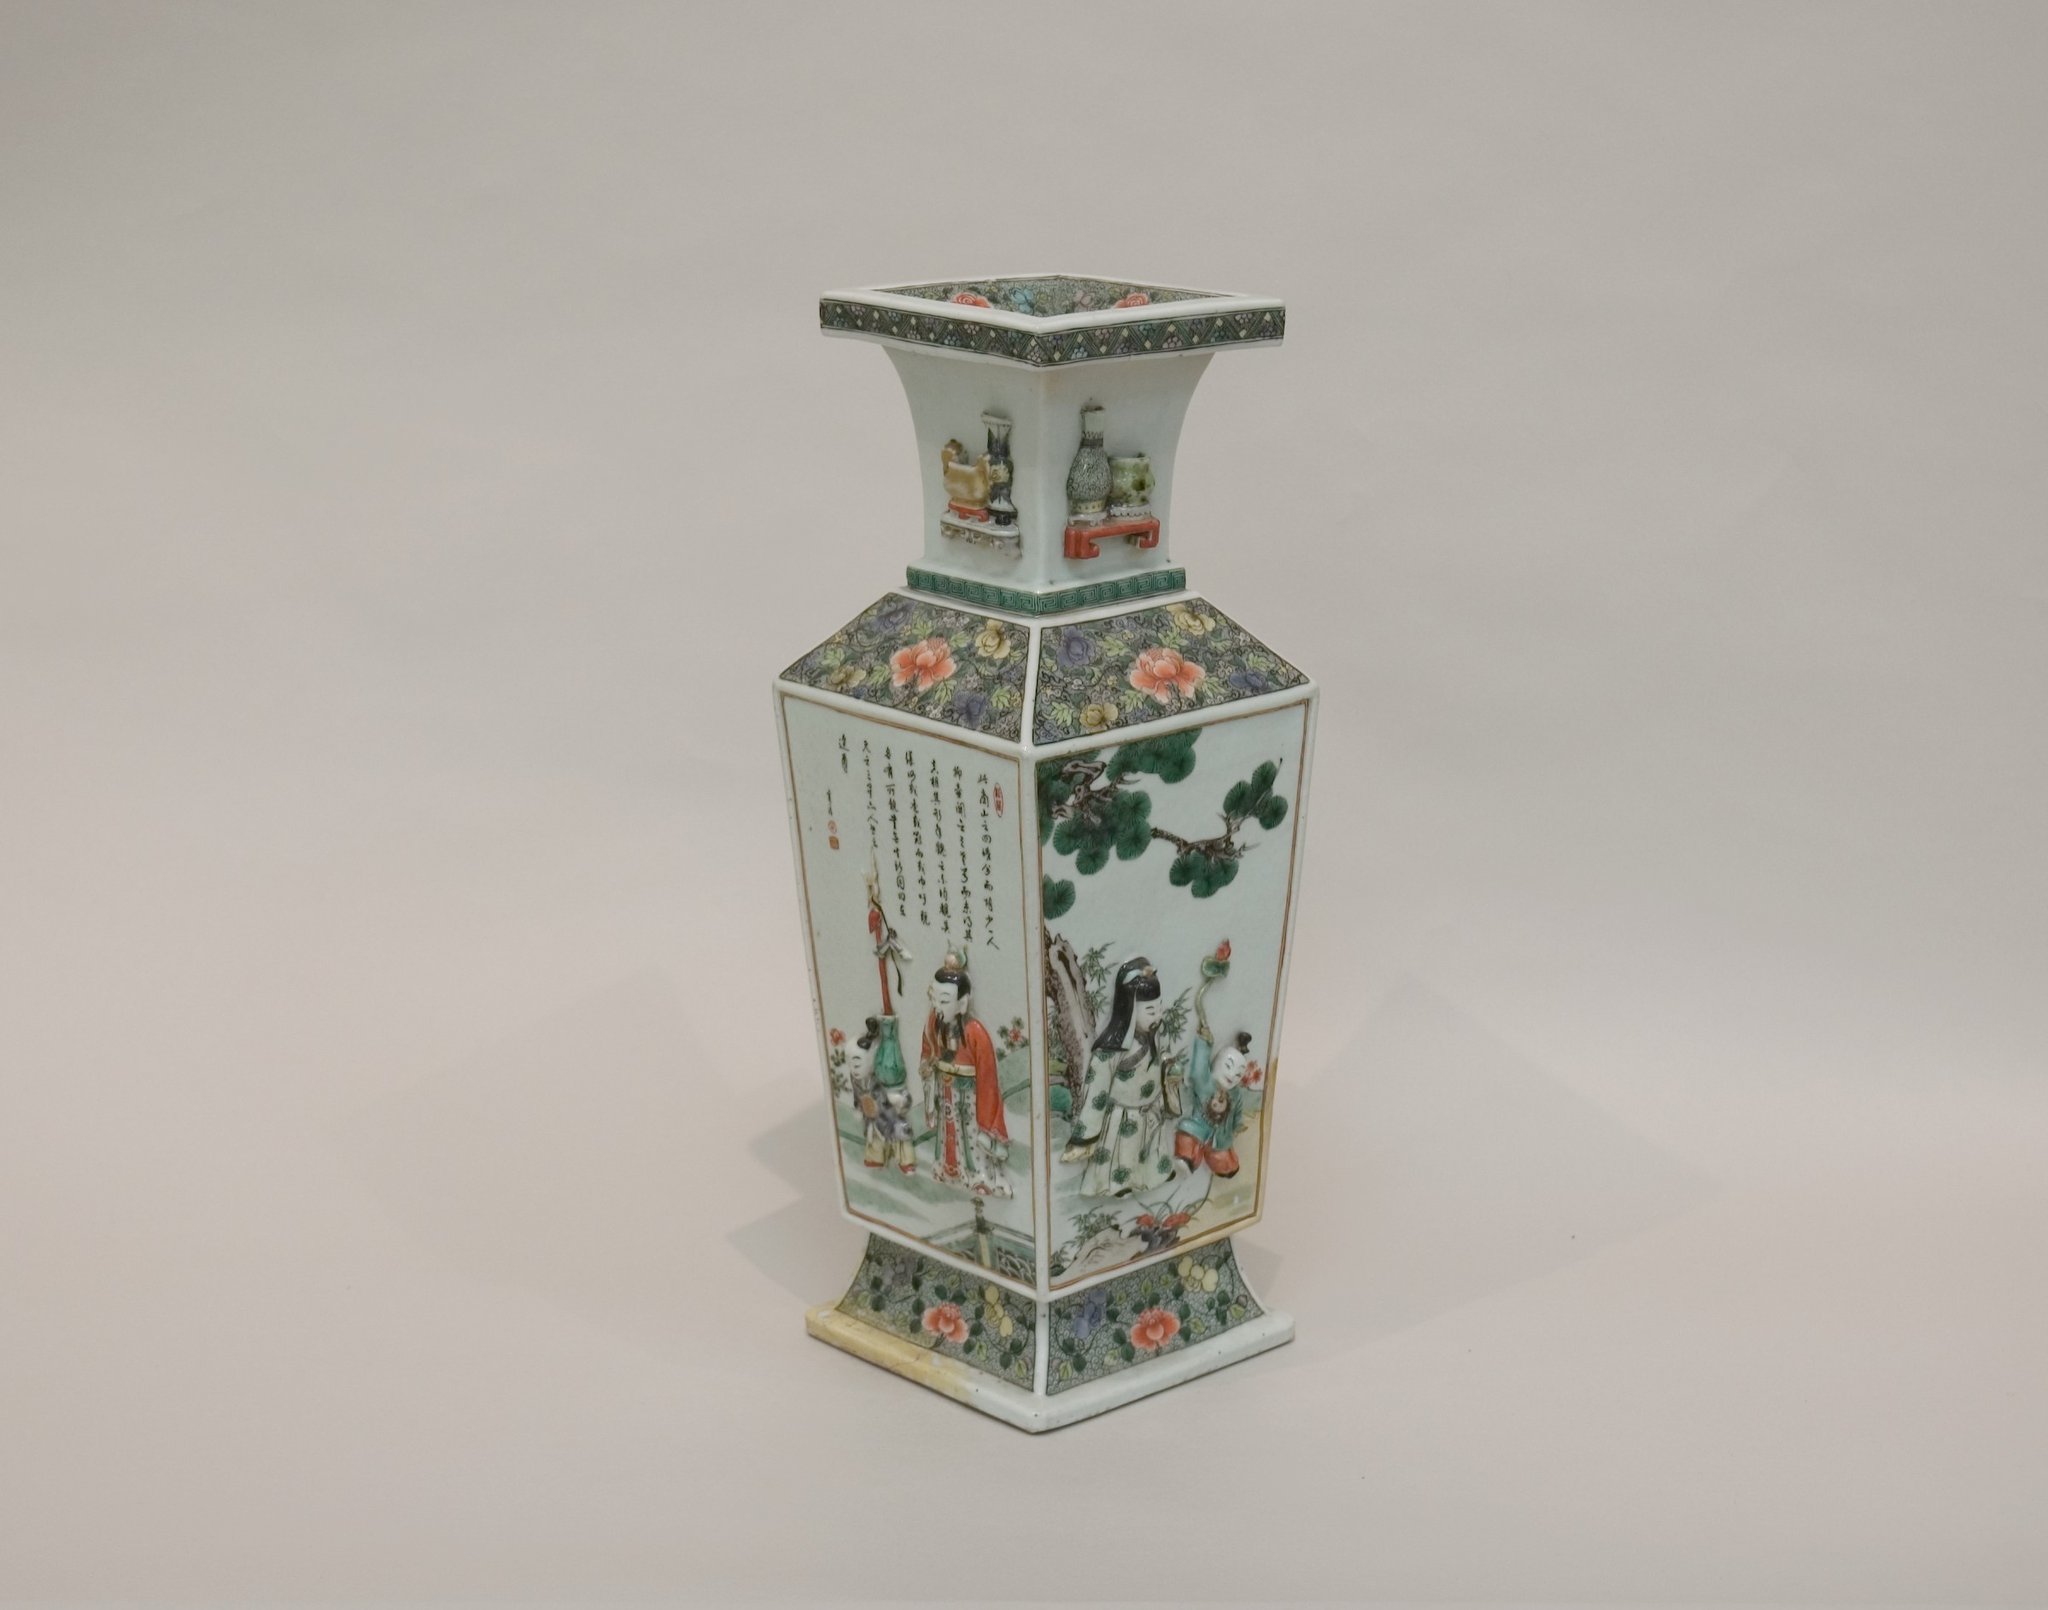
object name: vase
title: Vase with relief decoration of figures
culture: chinese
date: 1701-1733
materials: enamel, porcelain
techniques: overglaze, painting, polychrome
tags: men,women